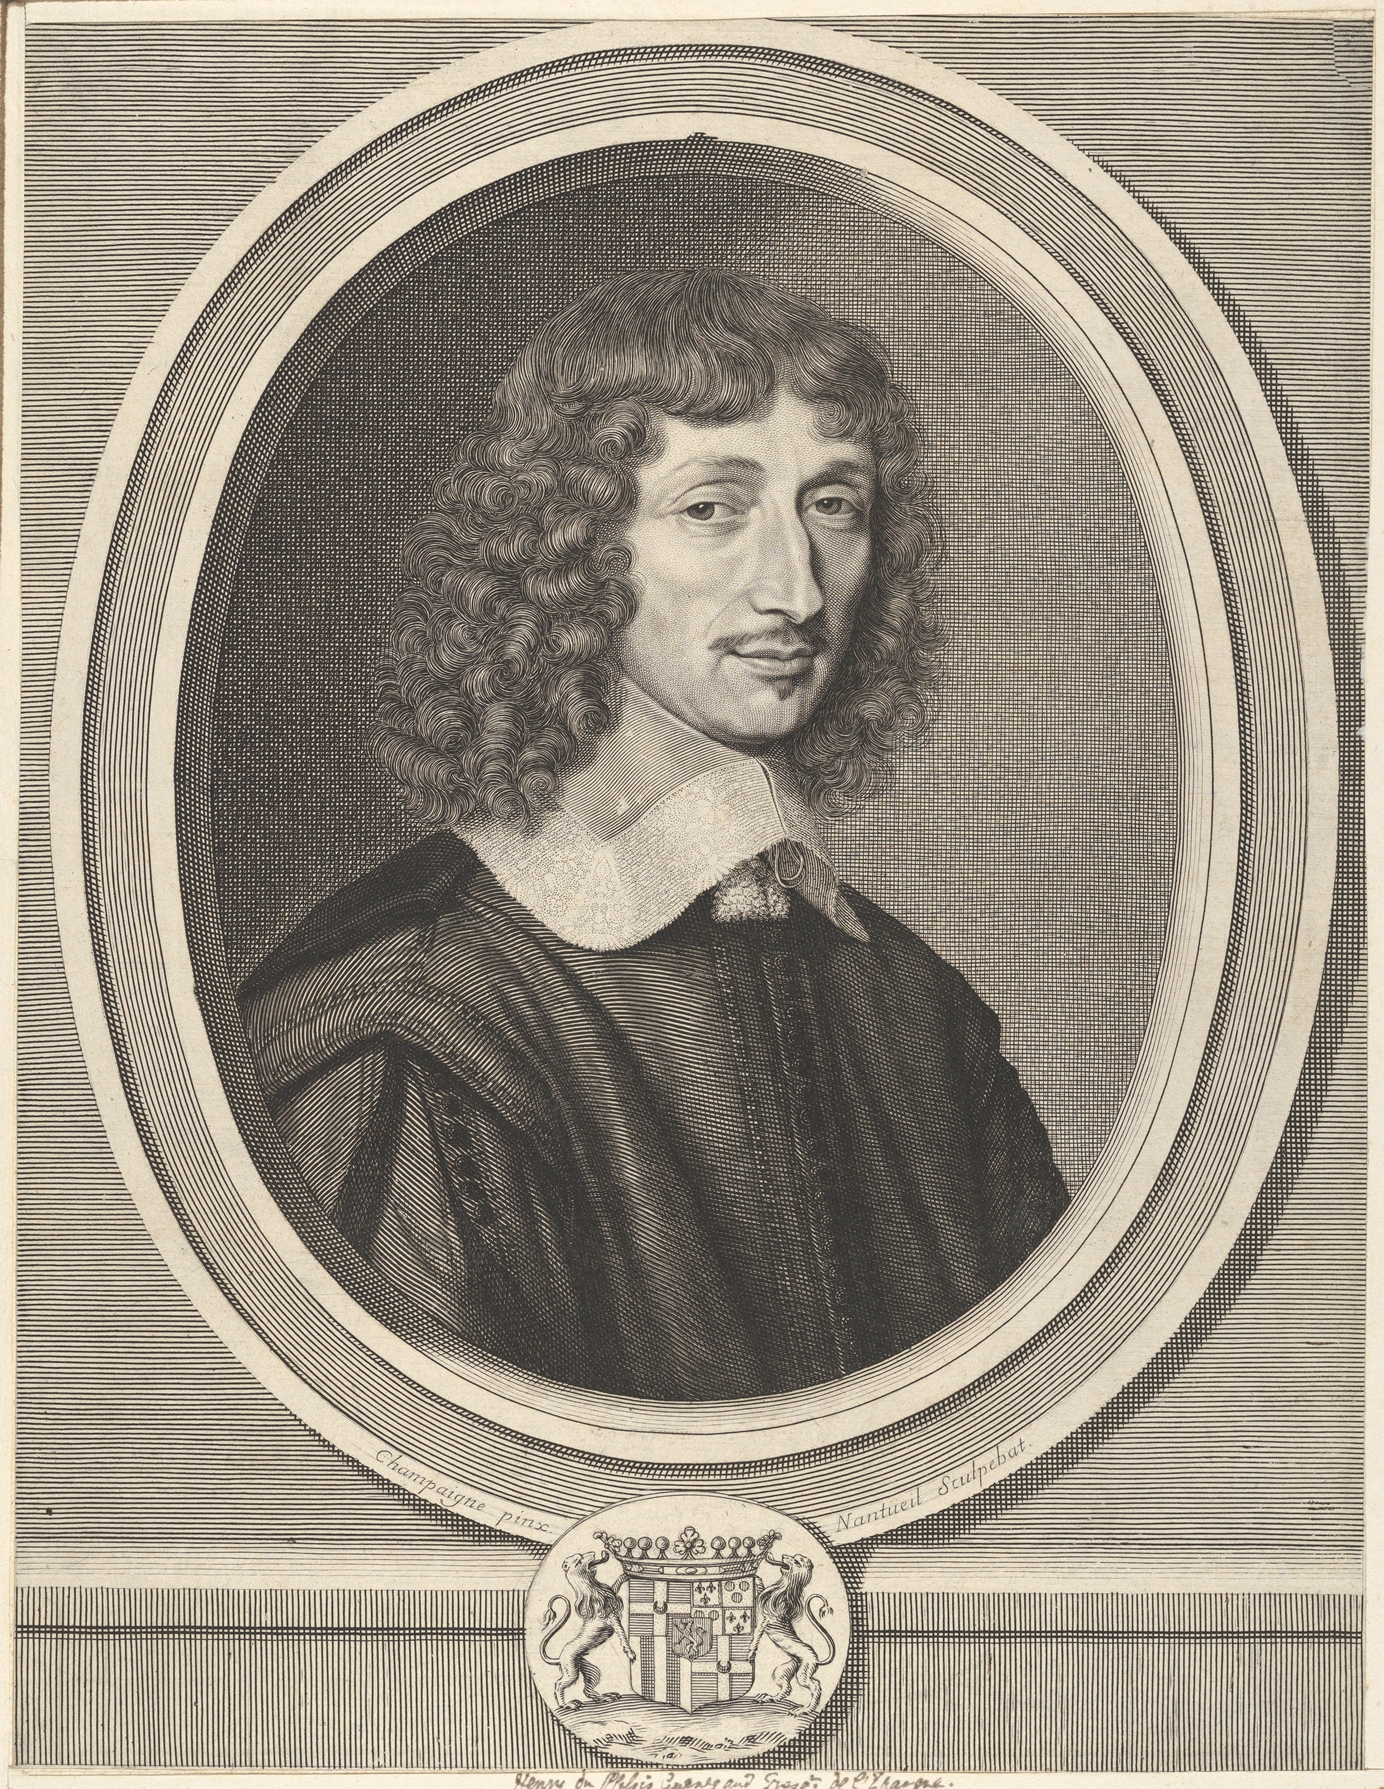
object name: print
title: Henri de Guénégaud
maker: robert nanteuil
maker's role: artist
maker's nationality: french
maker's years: 1623-1678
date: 1654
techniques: engraving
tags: men,portraits,coat of arms